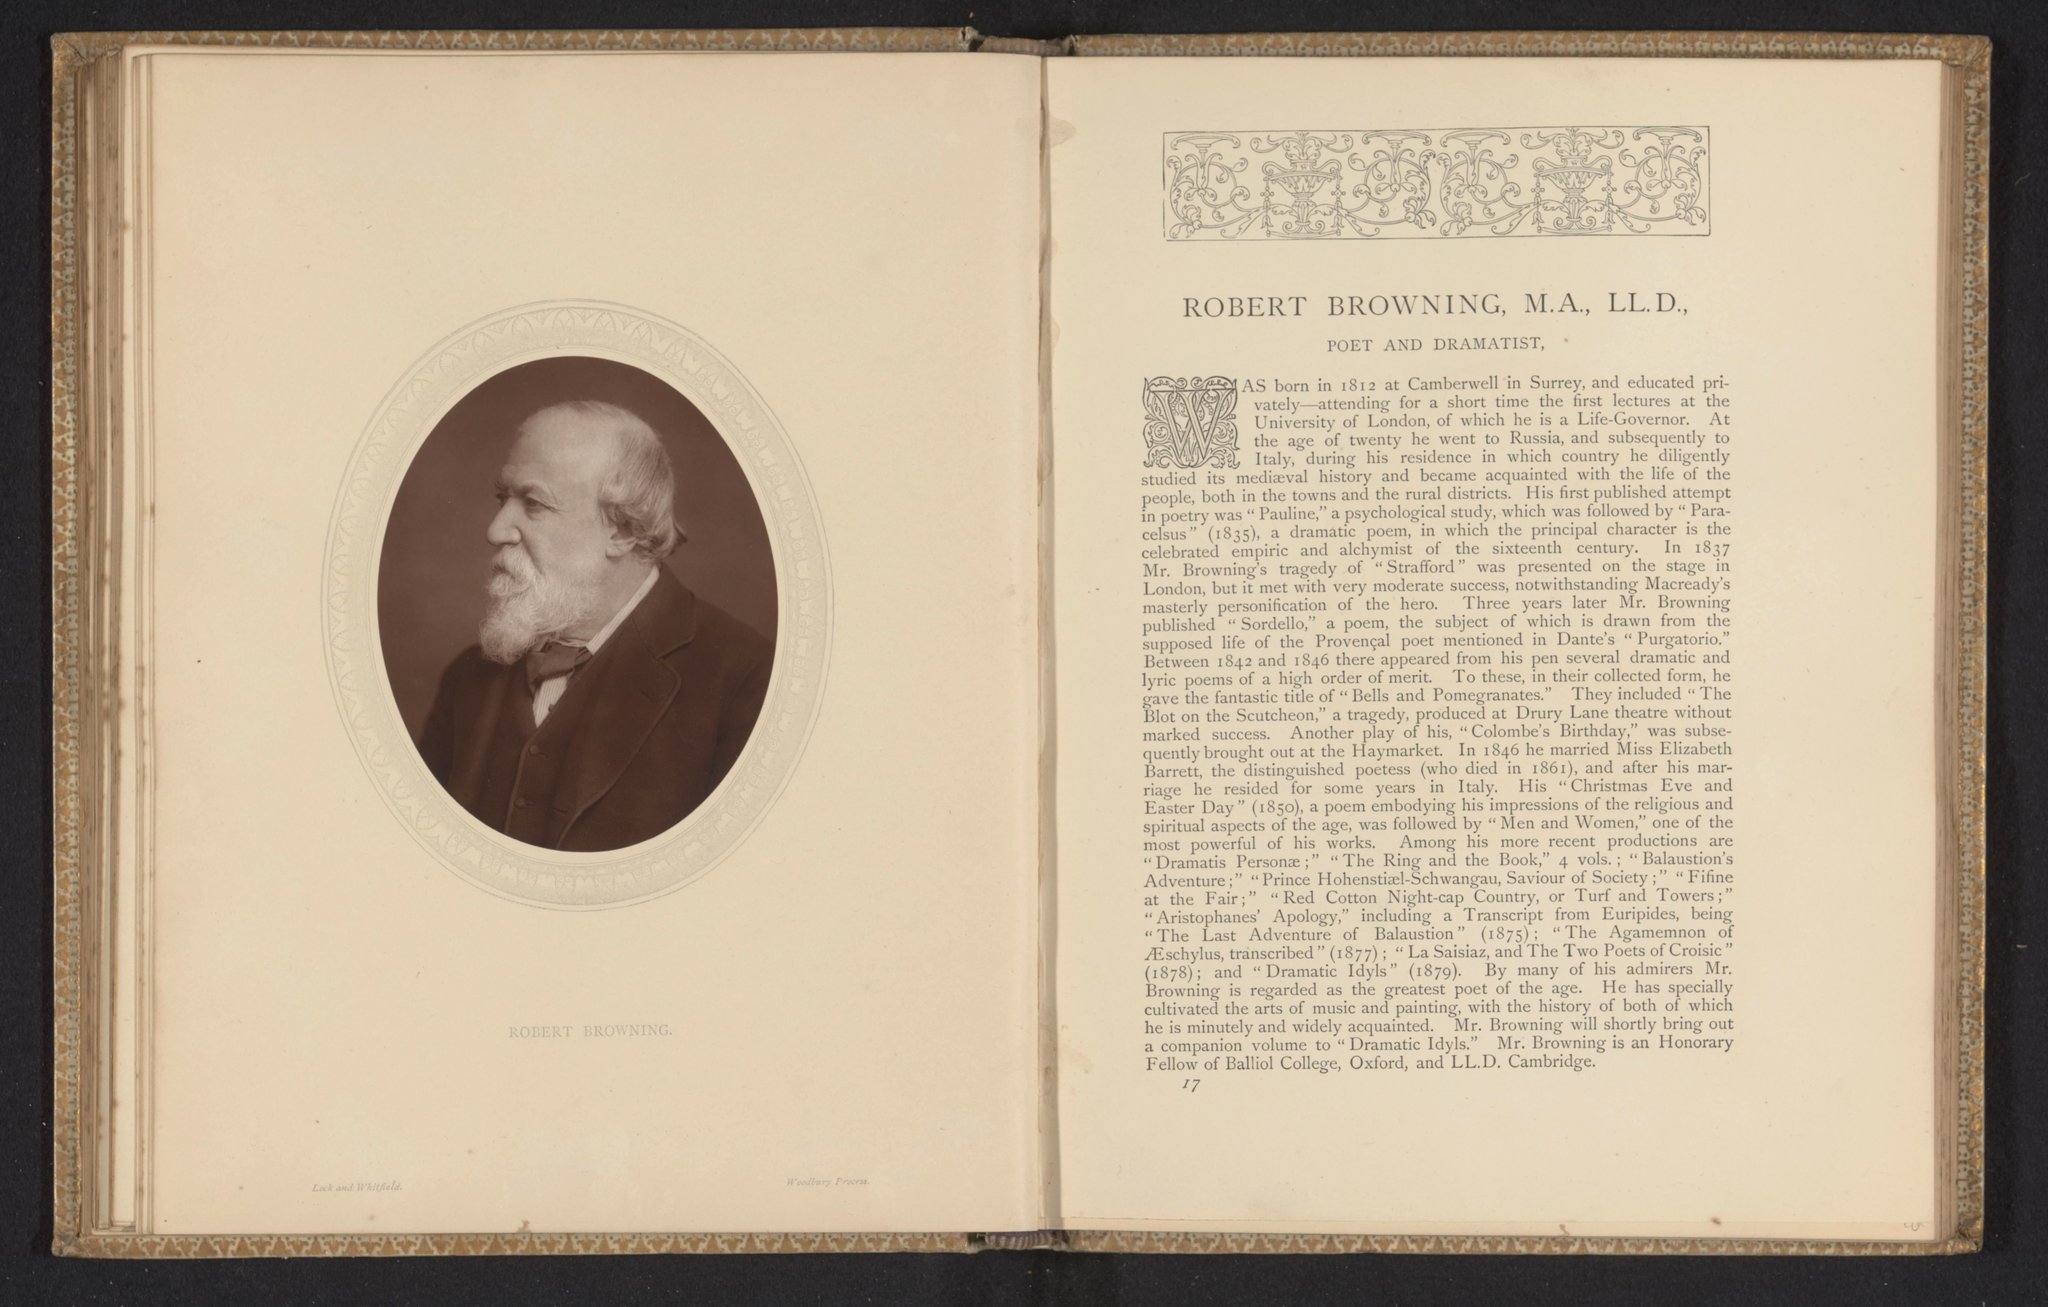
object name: page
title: Robert Browning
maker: Anonymous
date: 1876-1881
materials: paper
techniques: woodburytype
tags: historical persons (portraits and scenes from the life) (+ (full) bust portrait), writer, poet, author